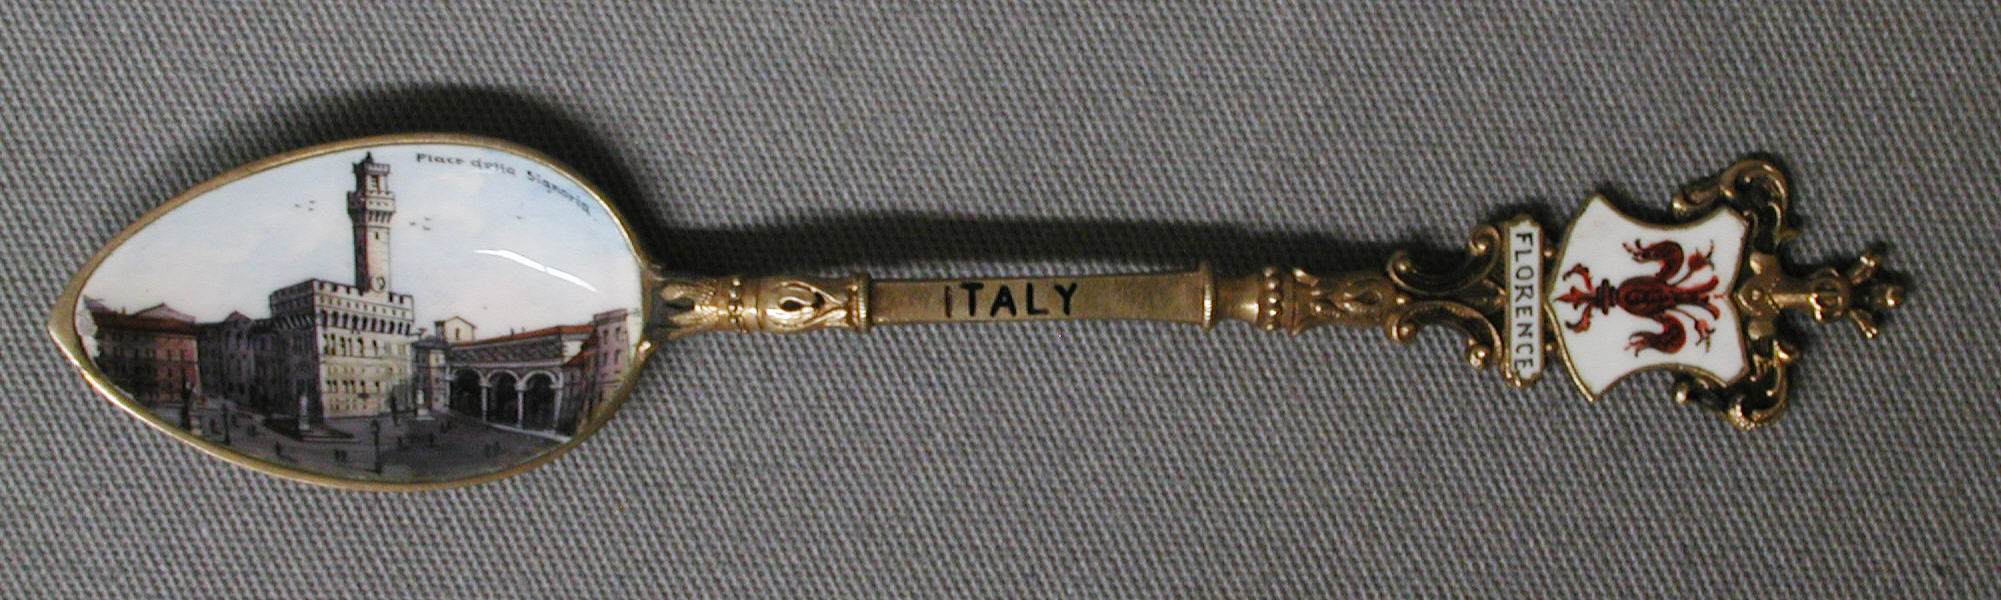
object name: souvenir spoon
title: Souvenir spoon with view of the Place della Signoria, Florence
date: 1867-1900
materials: enamel, silver gilt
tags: palaces,coat of arms